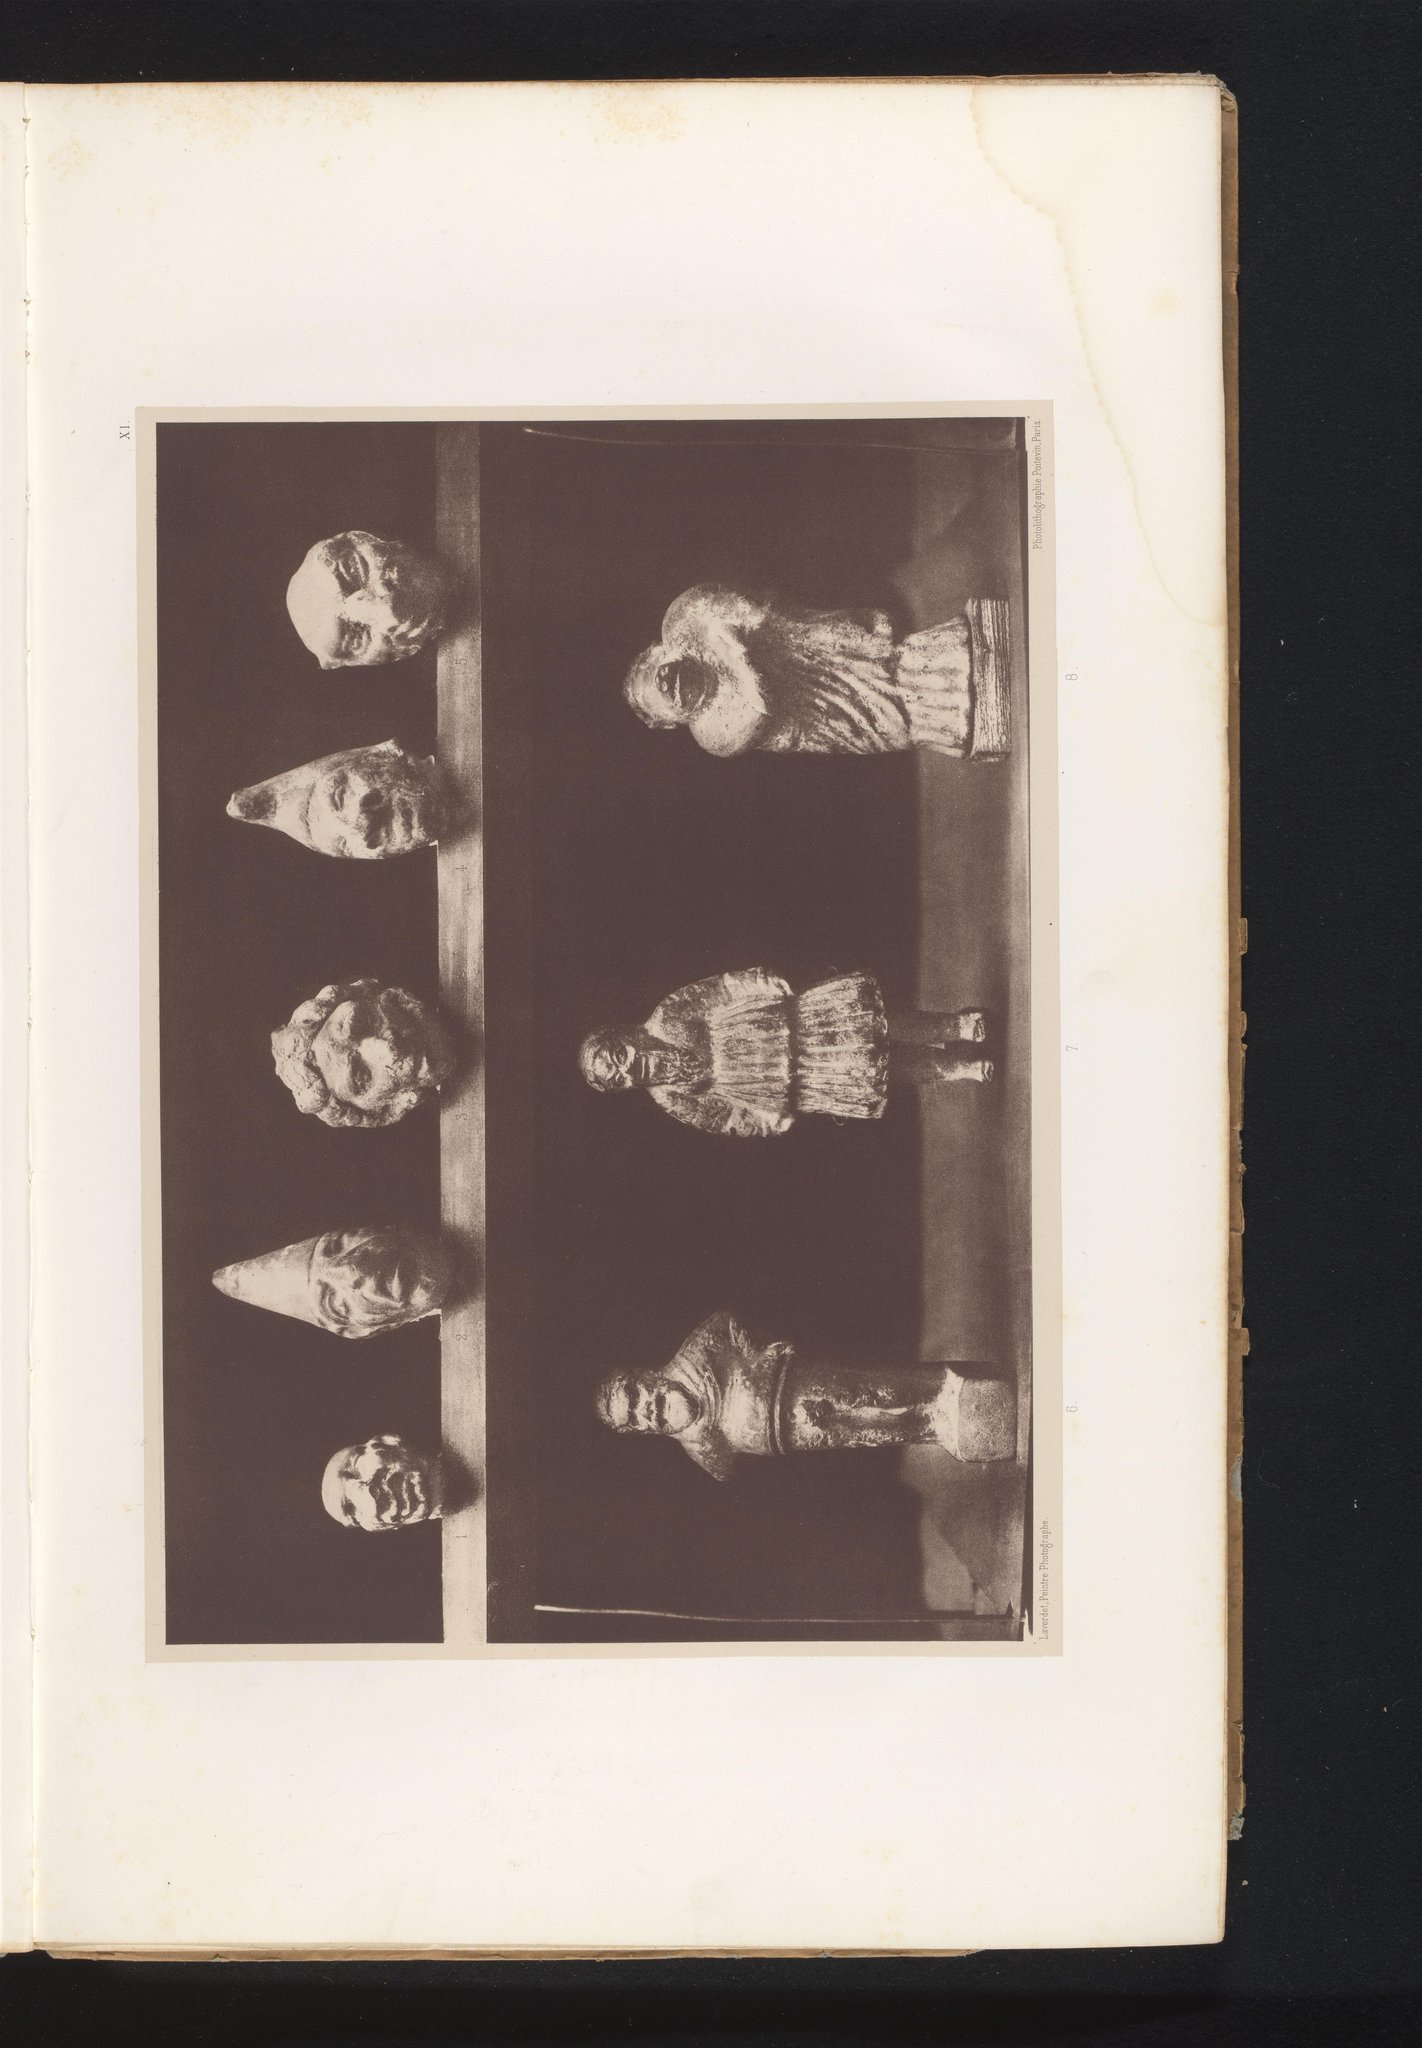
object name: photomechanical print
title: Acht terracotta sculpturen, bestaand uit vijf groteske hoofden, twee mannen en een groteske pop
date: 1852-1857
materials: paper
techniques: photolithography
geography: paris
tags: ornament ~ grotesque, piece of sculpture, reproduction of a piece of sculpture (+ clay, sand, etc. ~ arts)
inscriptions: number: ‘1. 2. 3. 4. 5./ 6. 7. 8.’, number: ‘XI.’